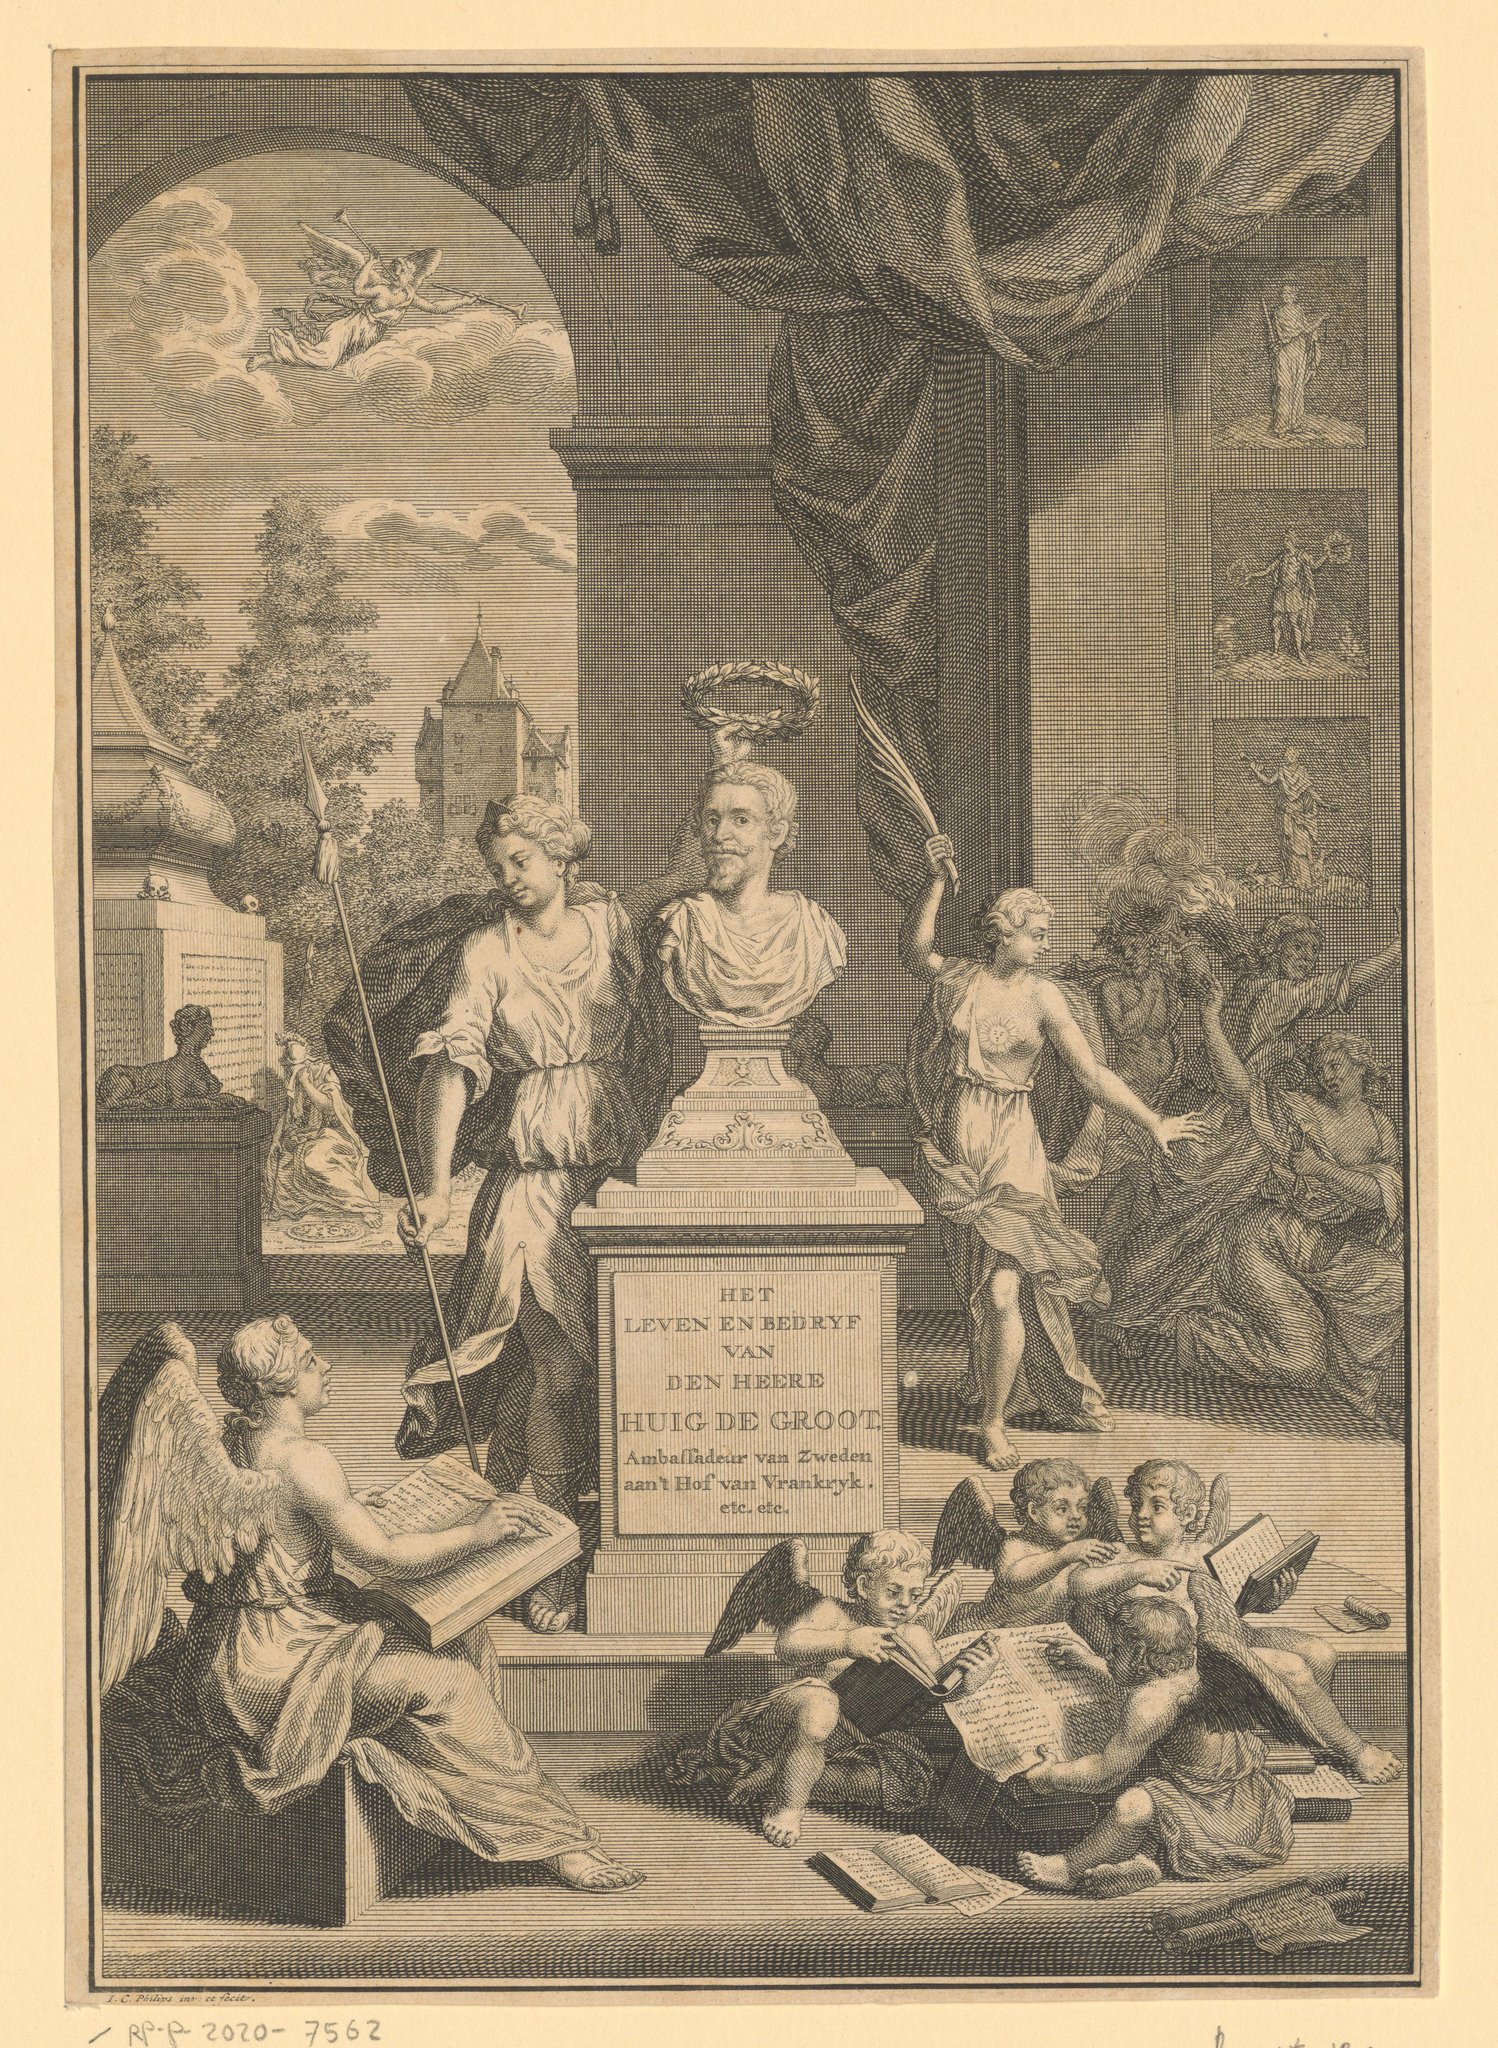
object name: book illustration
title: Buste van Hugo de Groot krijgt lauwerkrans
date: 1732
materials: paper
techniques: engraving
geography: amsterdam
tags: delft, hugo de groot, historical persons, portrait of a writer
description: Prent uit: Brandt, Caspar en Adriaan van Cattenburgh. Historie van het leven des heeren Huig de Groot. Dordrecht: Johannes van Braam, Amsterdam: Adriaan Wor, erven Gerard Onder de Linden, 1732, tegenover de titelpagina.